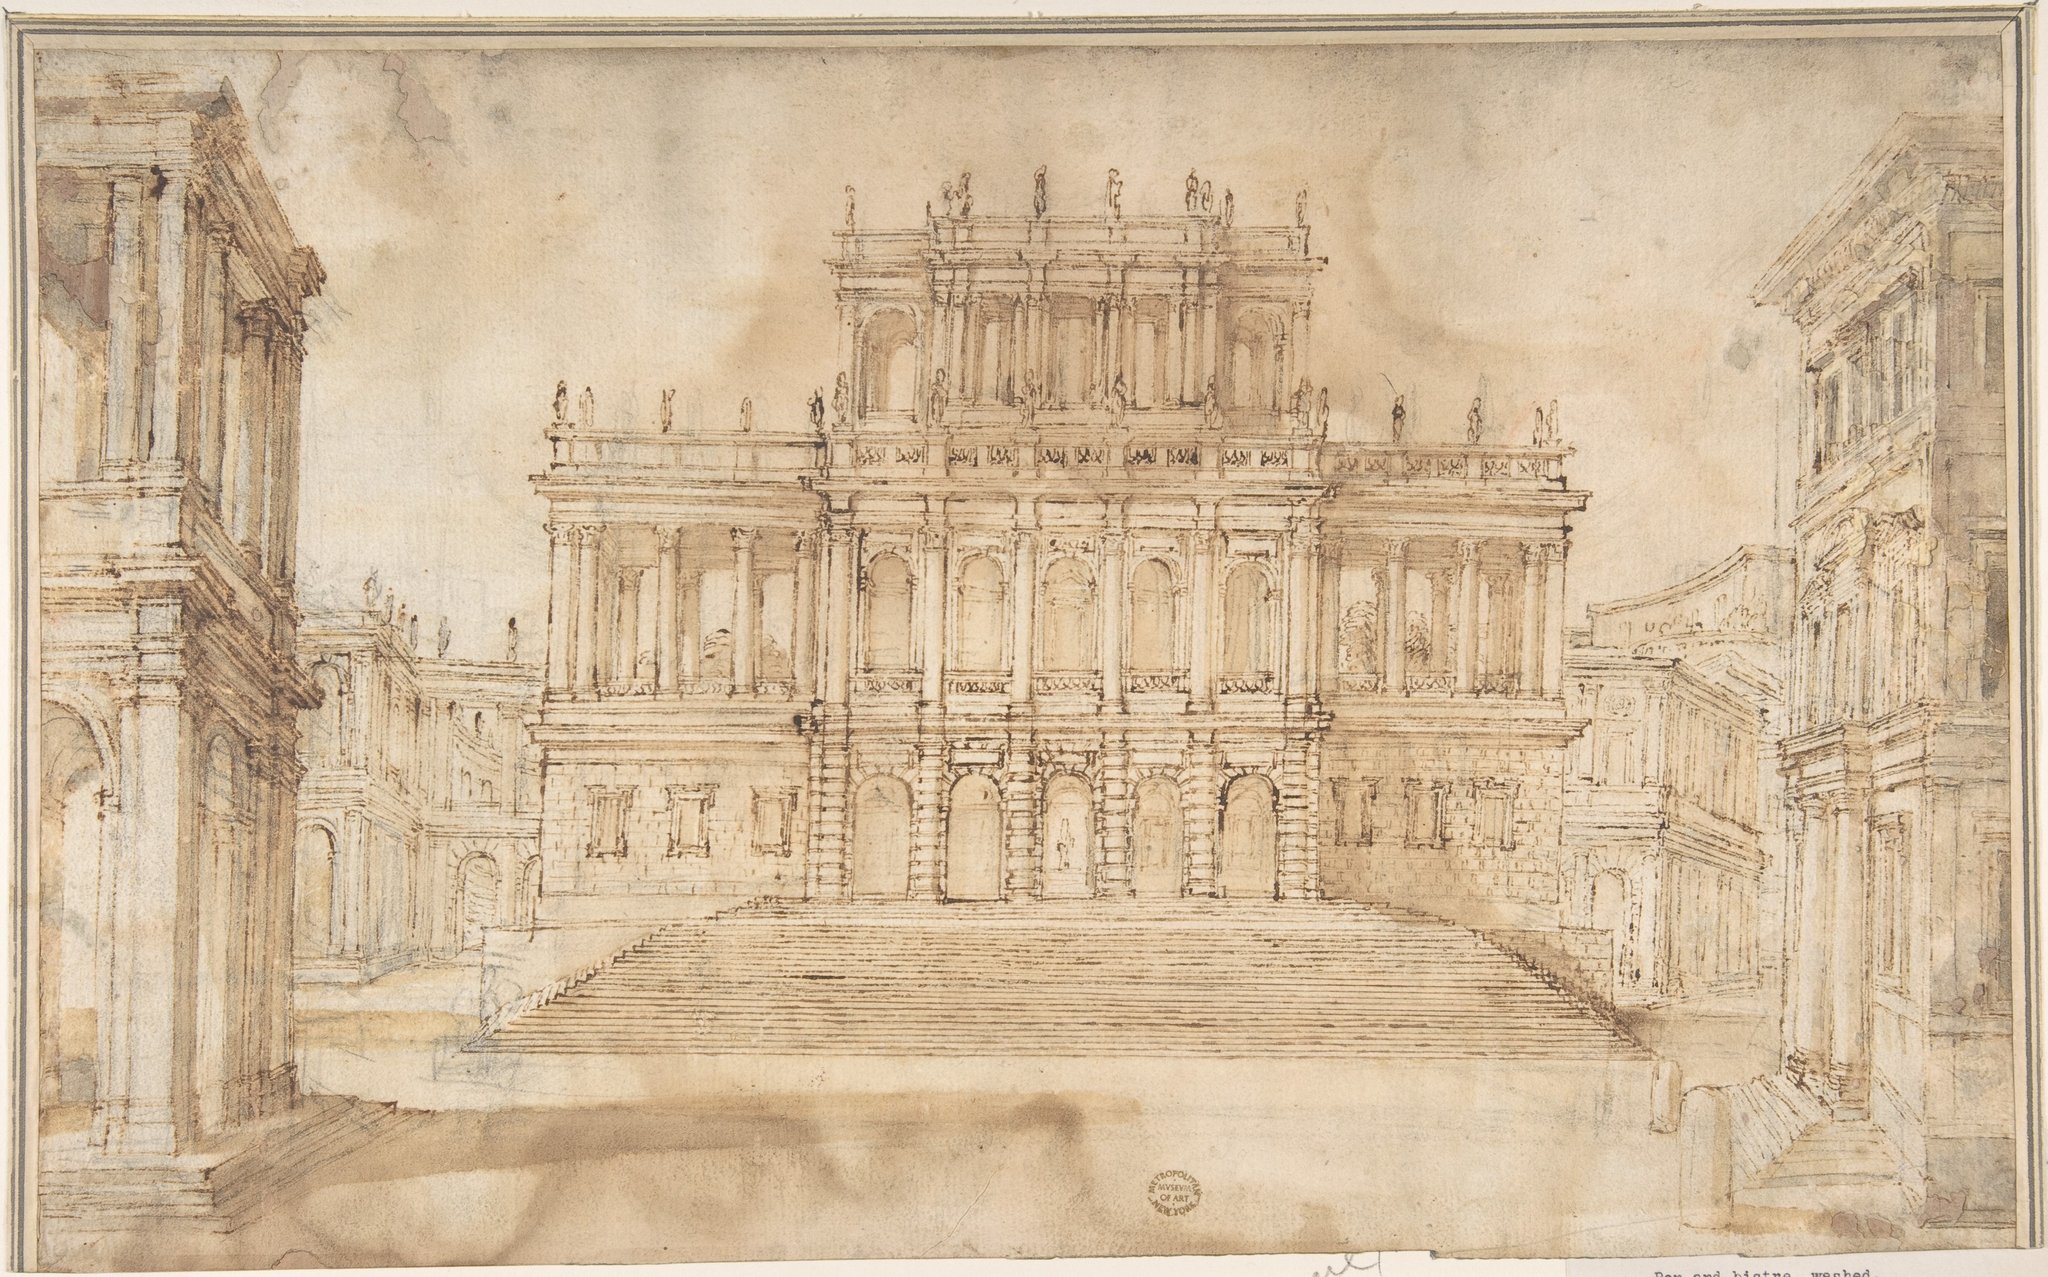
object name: drawing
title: Design for Stage Set with Porticoed Palazzo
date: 1701-1800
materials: chalk, ink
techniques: pen, wash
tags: buildings,stage design